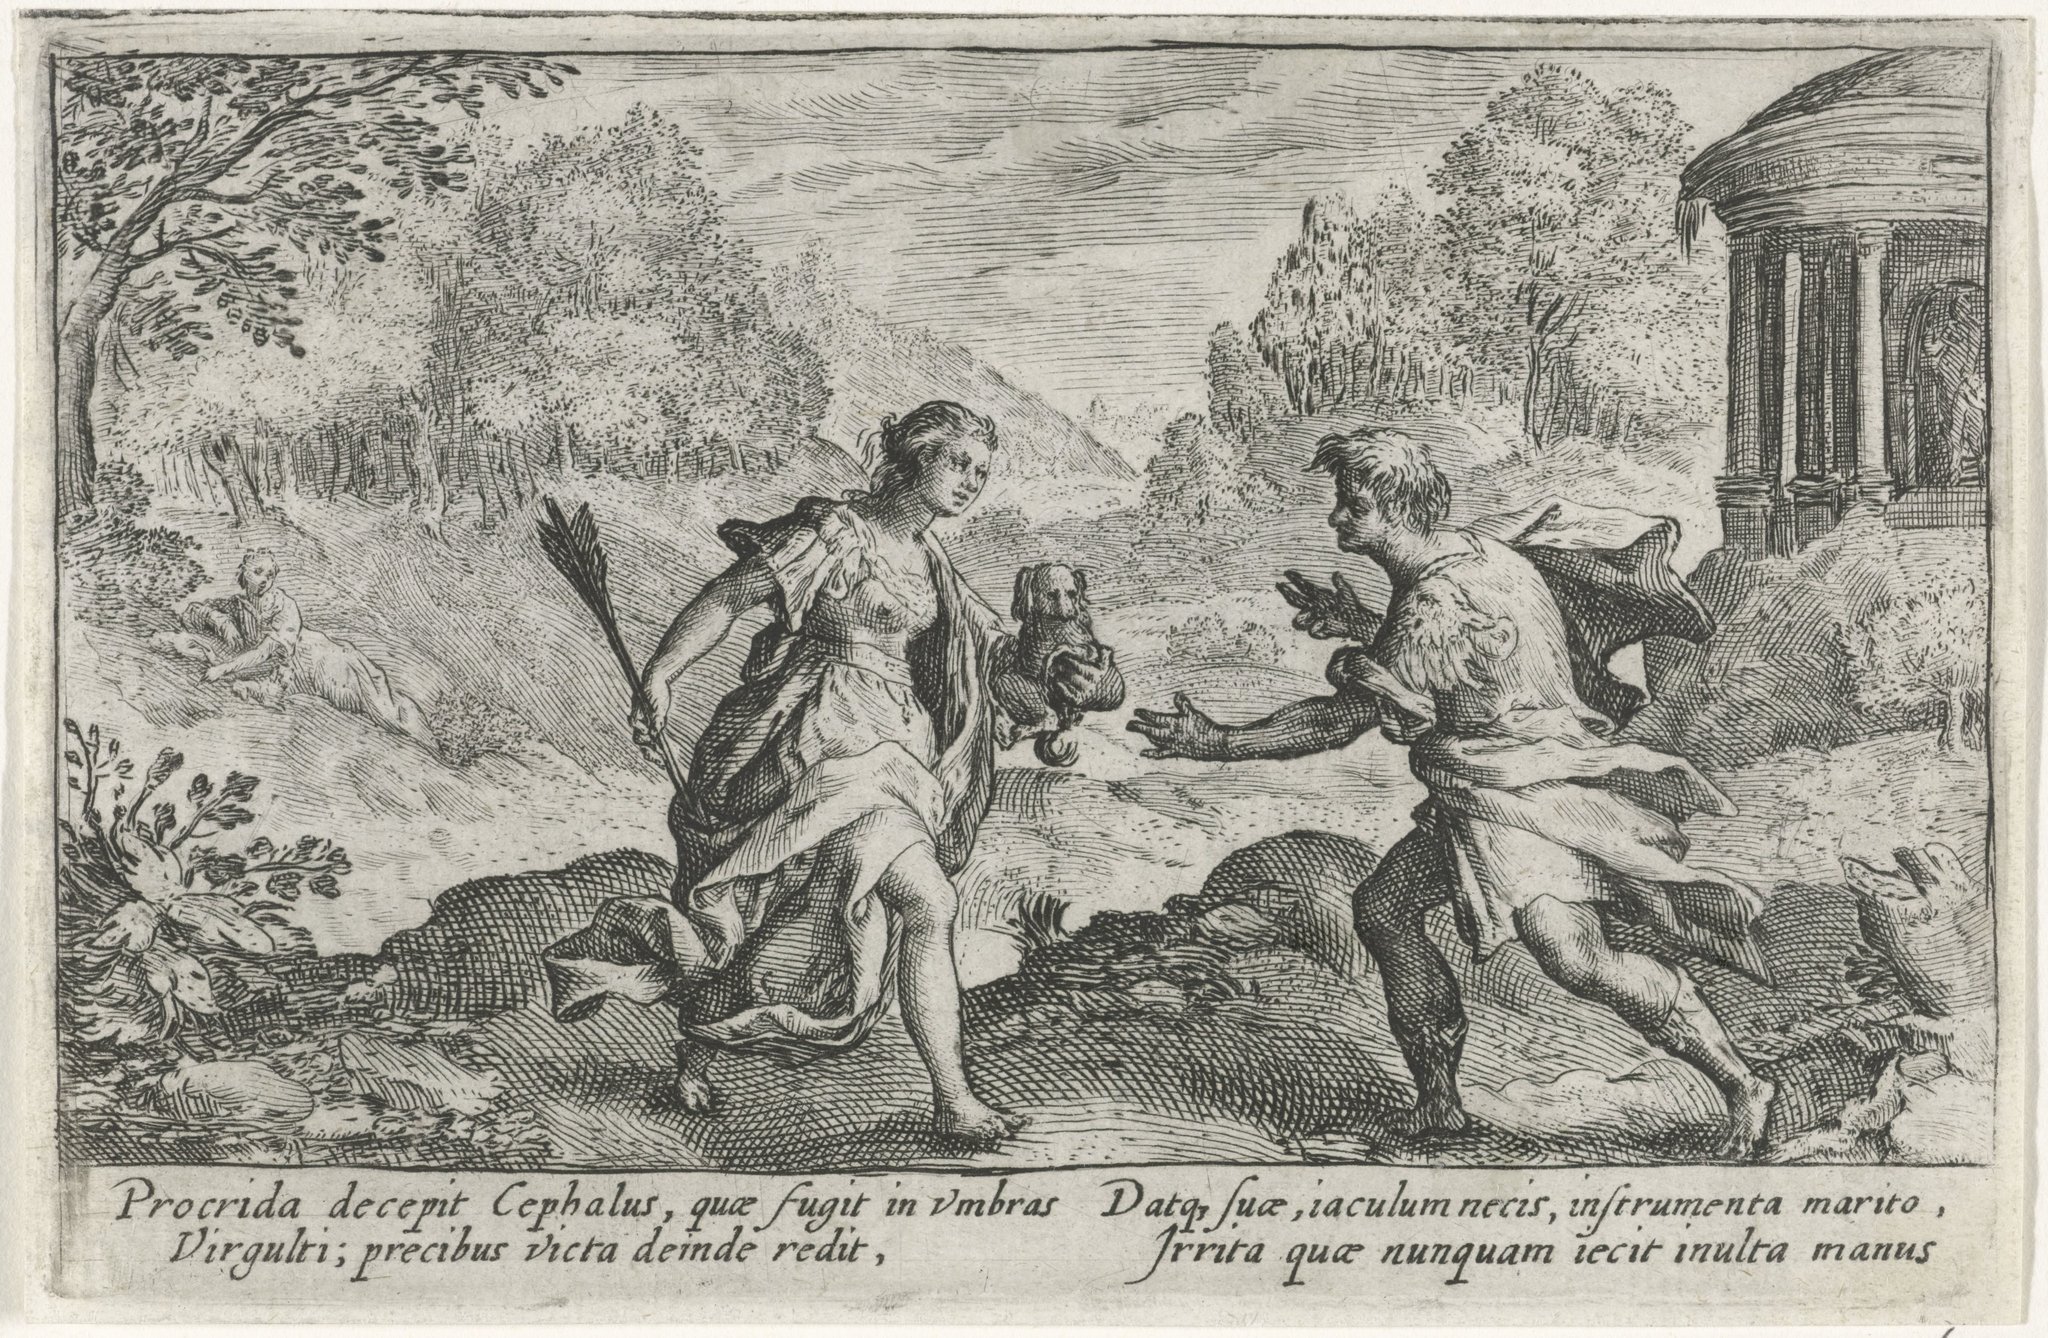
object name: print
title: Cephalus en Procris verzoenen zich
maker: crispijn van de passe (i)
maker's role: draughtsman, print maker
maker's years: 1564-1637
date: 1602-1607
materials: paper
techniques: engraving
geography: cologne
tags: procris gives cephalus the dog (laelaps) and the magic spear she received from diana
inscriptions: collector's mark: Lugt 2228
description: Procris brengt voor haar man twee geschenken mee die zij van Diana gekregen had: een jachthond en een magische speer die altijd doel treft. In de marge een vierregelig onderschrift, in twee kolommen, in het Latijn.